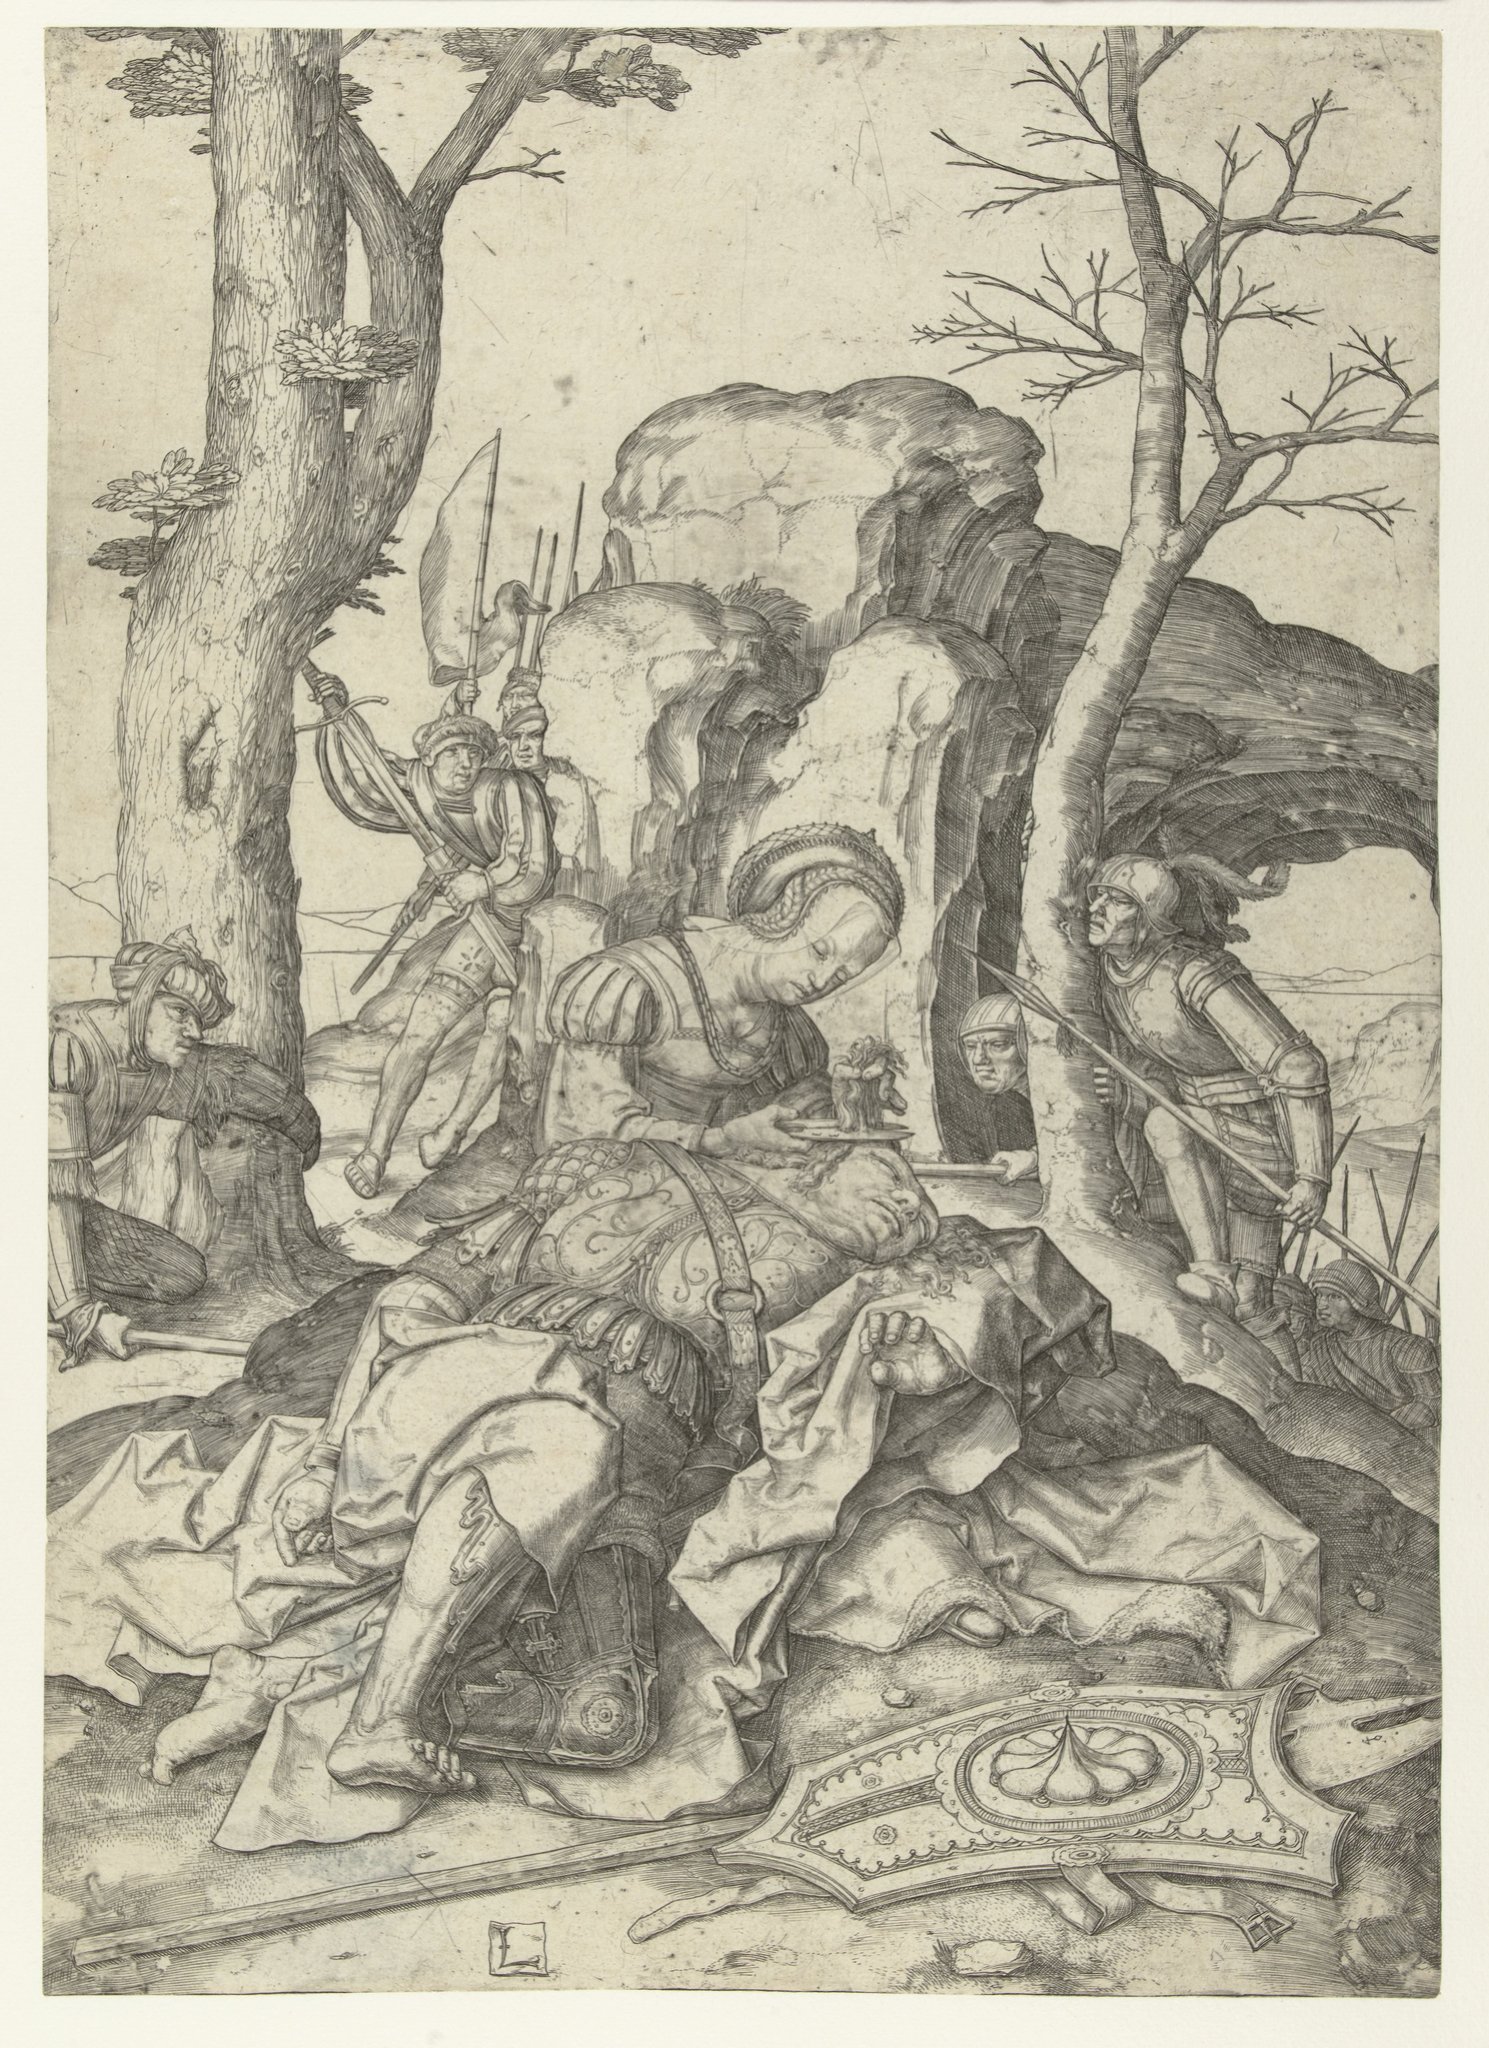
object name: print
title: Simson en Delila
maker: lucas van leyden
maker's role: draughtsman, painter, print maker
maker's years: 1494-1533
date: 1502-1509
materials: paper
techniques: engraving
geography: low countries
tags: samson's hairlocks are cut off by delilah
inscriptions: inscription: ‘P. Mariette 1647’, collector's mark: Lugt 2009, collector's mark: Lugt 2760, collector's mark: Lugt 2228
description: Delila knipt het haar af van Simson slapend op haar schoot. Aantal gewapende mannen staat klaar om aan te vallen.